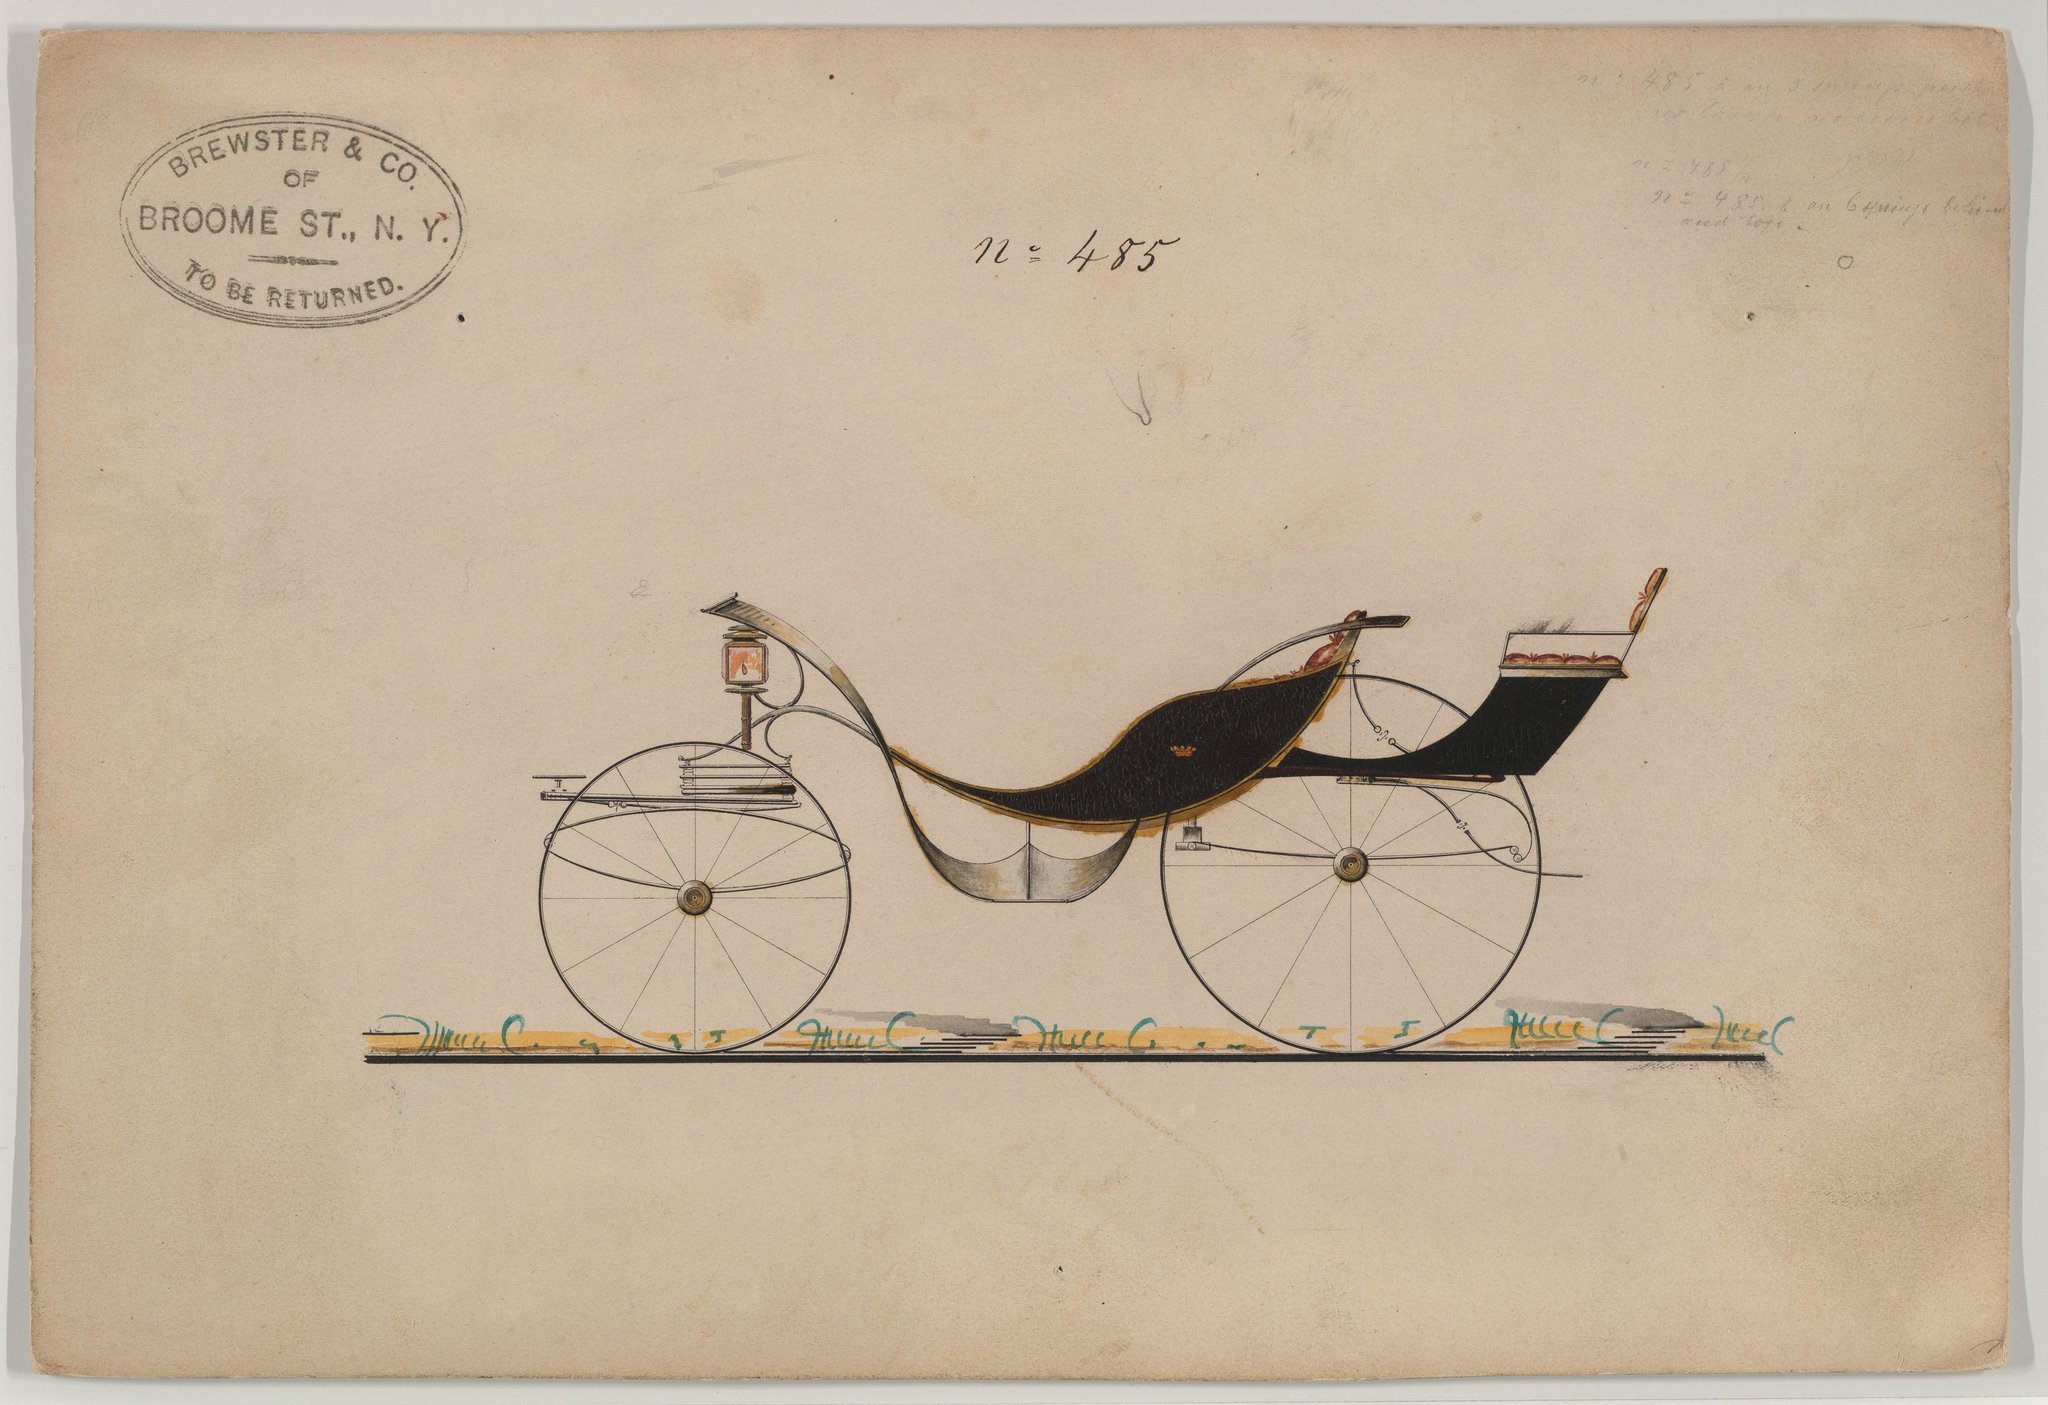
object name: drawing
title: Victoria/Phaeton #485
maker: brewster & co.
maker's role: manufacturer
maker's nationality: american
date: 1860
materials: gouache, gum arabic, ink, watercolor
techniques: pen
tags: carriages